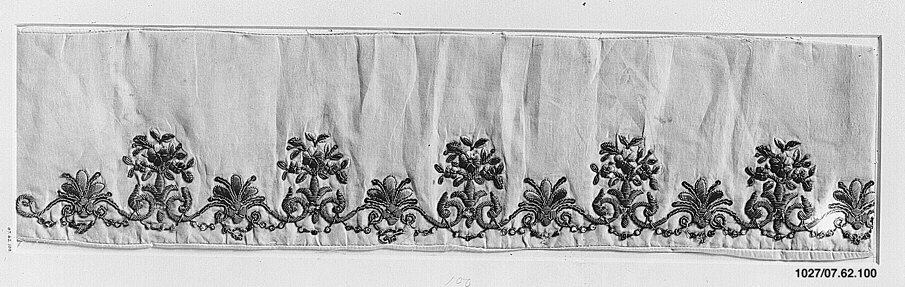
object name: piece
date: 1767-1800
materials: metal thread, silk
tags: flowers,leaves